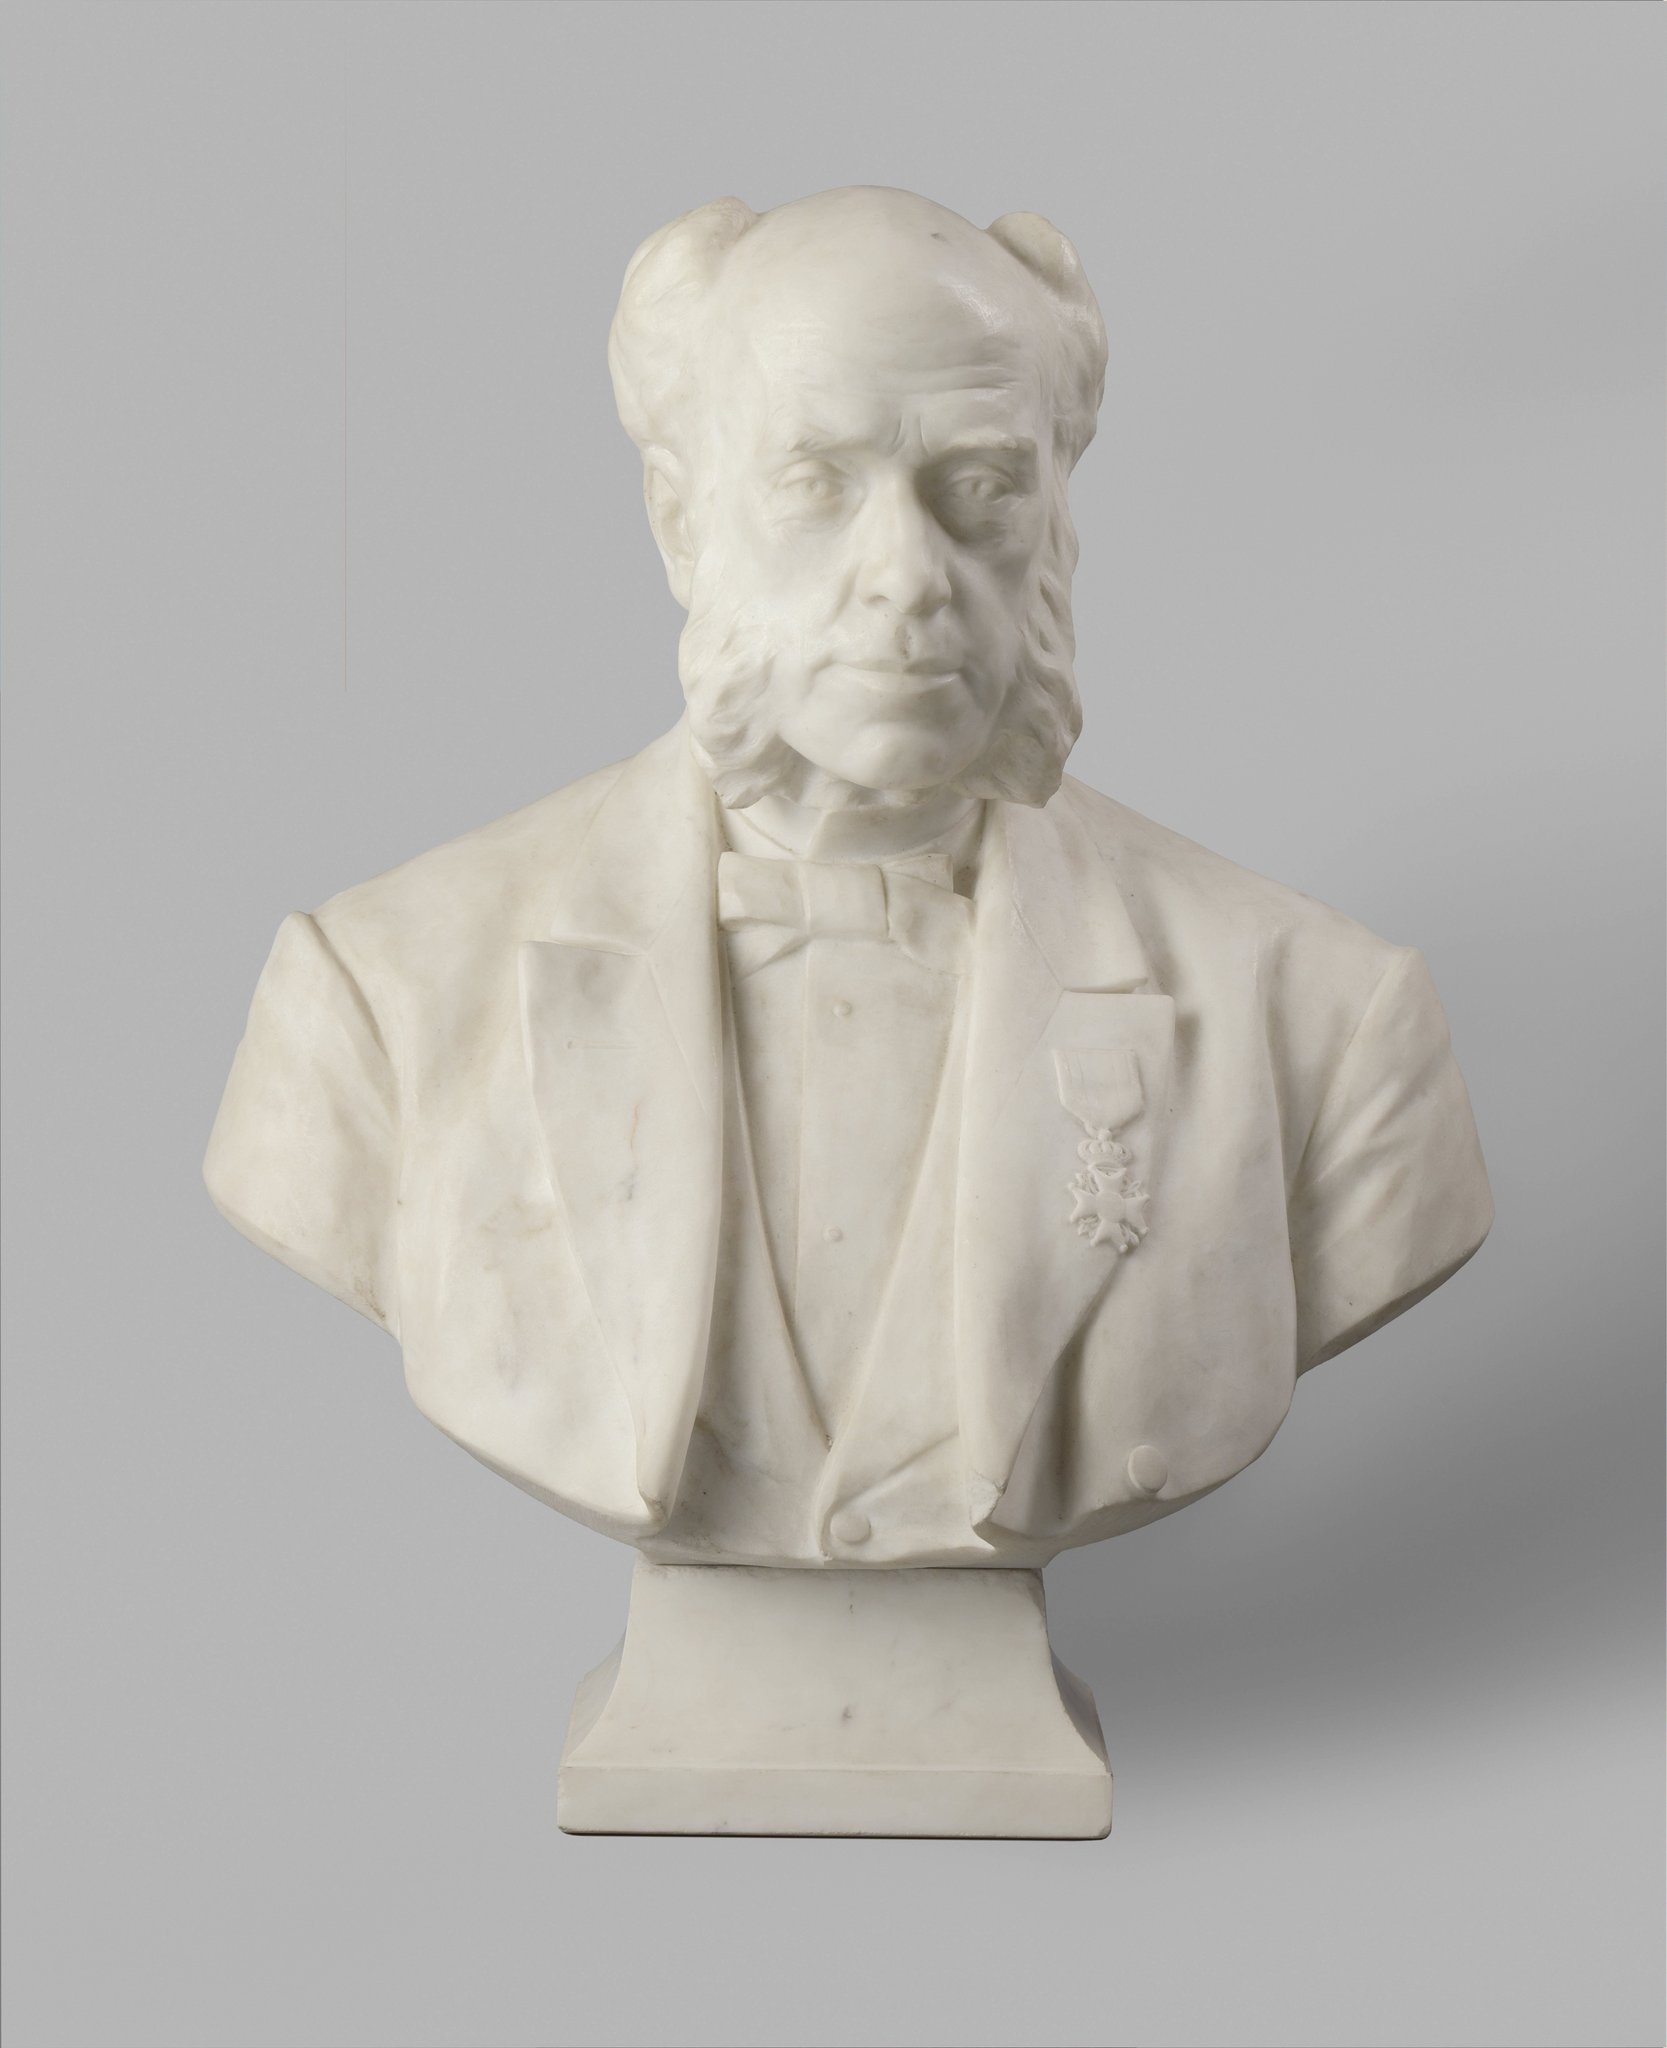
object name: bust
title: Buste van dr. Eliza Laurillard (1830-1908), dominee en schrijver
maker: arend willem maurits odé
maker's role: sculptor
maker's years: 1865-1955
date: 1894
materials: marble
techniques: carved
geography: netherlands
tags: eliza laurillard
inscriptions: signature: ‘Odé 1894’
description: Arend Willem Maurits Odé (1865 - 1955). Reverend Eliza Laurillard (1830 - 1908). Marble, 1894. Eliza Laurillard was the most celebrated minister active in the second half of the 19th century. Not only did he preach in Amsterdam for 42 years, he also regularly mounted the pulpit of the royal chapel in Het Loo. In addition, Laurillard made a name for himself as a man of letters. According to a contemporary source, his devotional but light-hearted verses and stories were read 'in hovels and in palaces'. The sculptor Odé did this bust on the occasion of Laurillard's 40th jubilee as a minister.